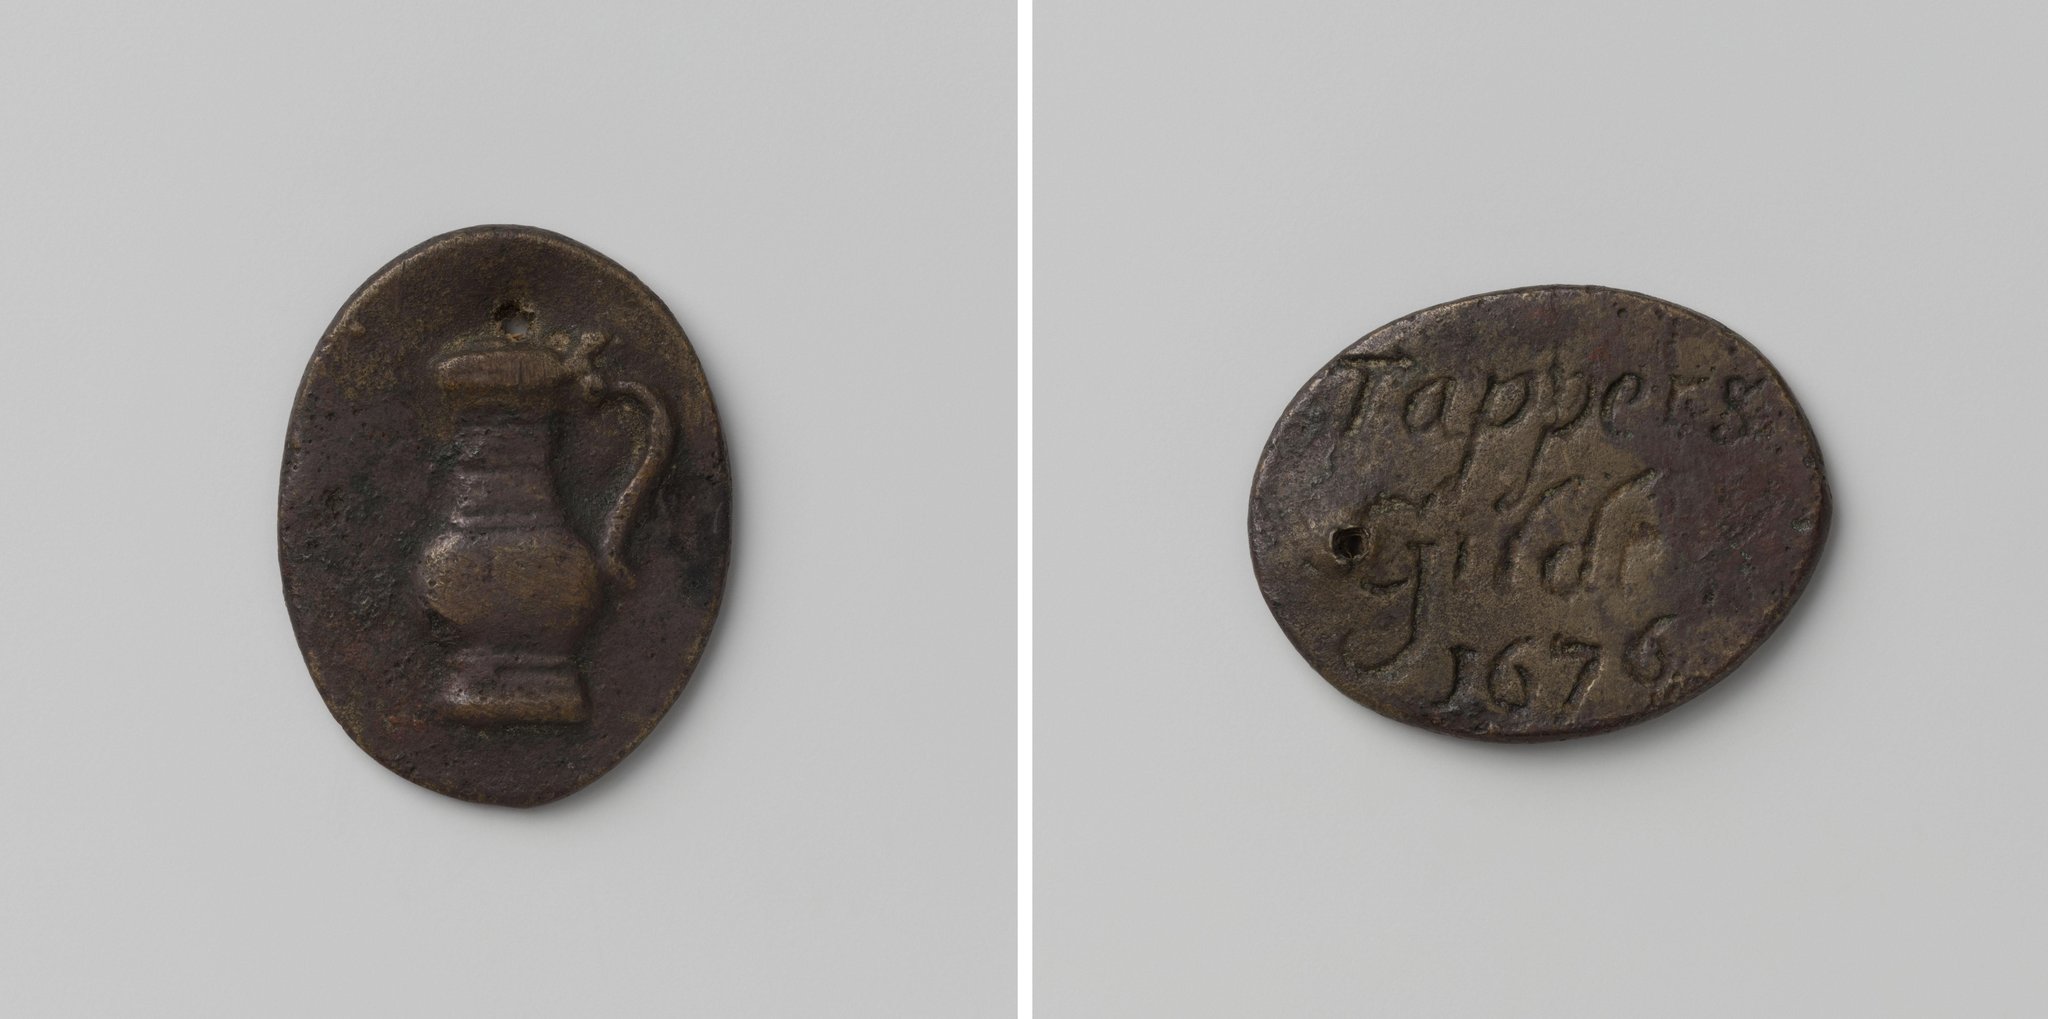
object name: medal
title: Tappersgilde van Deventer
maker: Anonymous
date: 1676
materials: brass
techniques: engraving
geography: deventer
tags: deventer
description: Messing ovale penning met gat erin. Voorzijde: schenkkan. Keerzijde: opschrift.